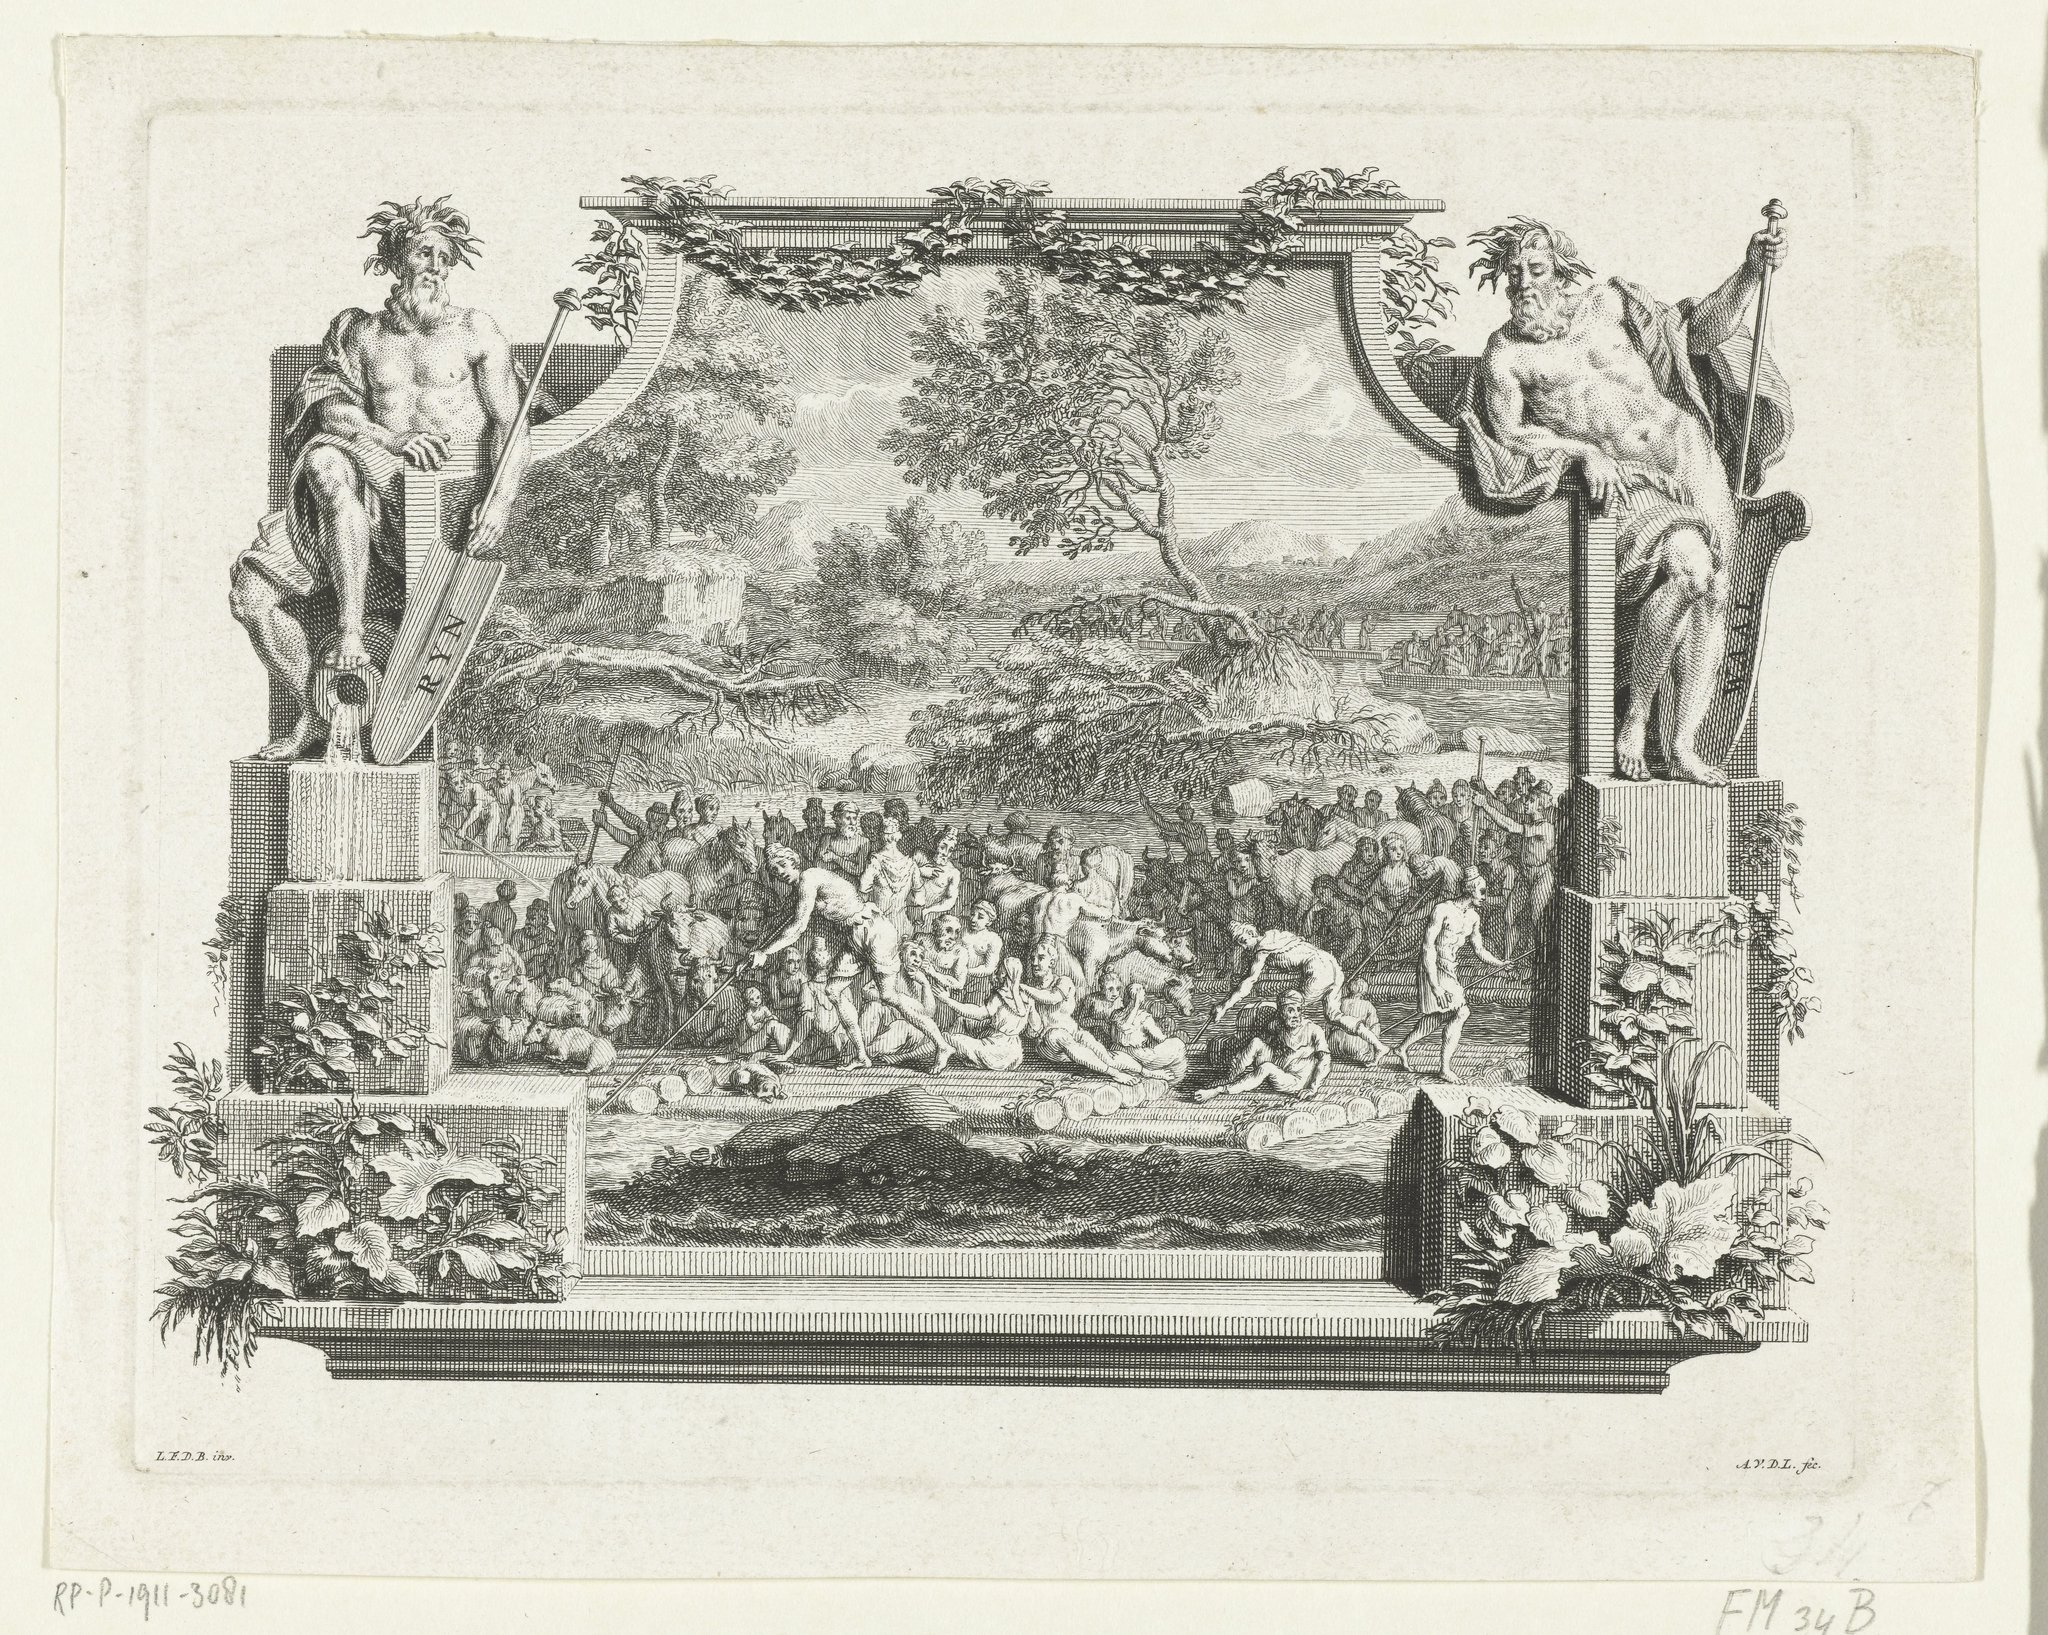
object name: history print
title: Aankomst van de Bataven hier te lande, ca. 55-10 v.C.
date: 1700-1755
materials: paper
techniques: etching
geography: netherlands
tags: extinct, 'historical' peoples (with name), netherlands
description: De aankomst van de Bataven hier te lande. In ornamentele omlijsting geflankeerd door riviergoden van de Rijn en Waal.